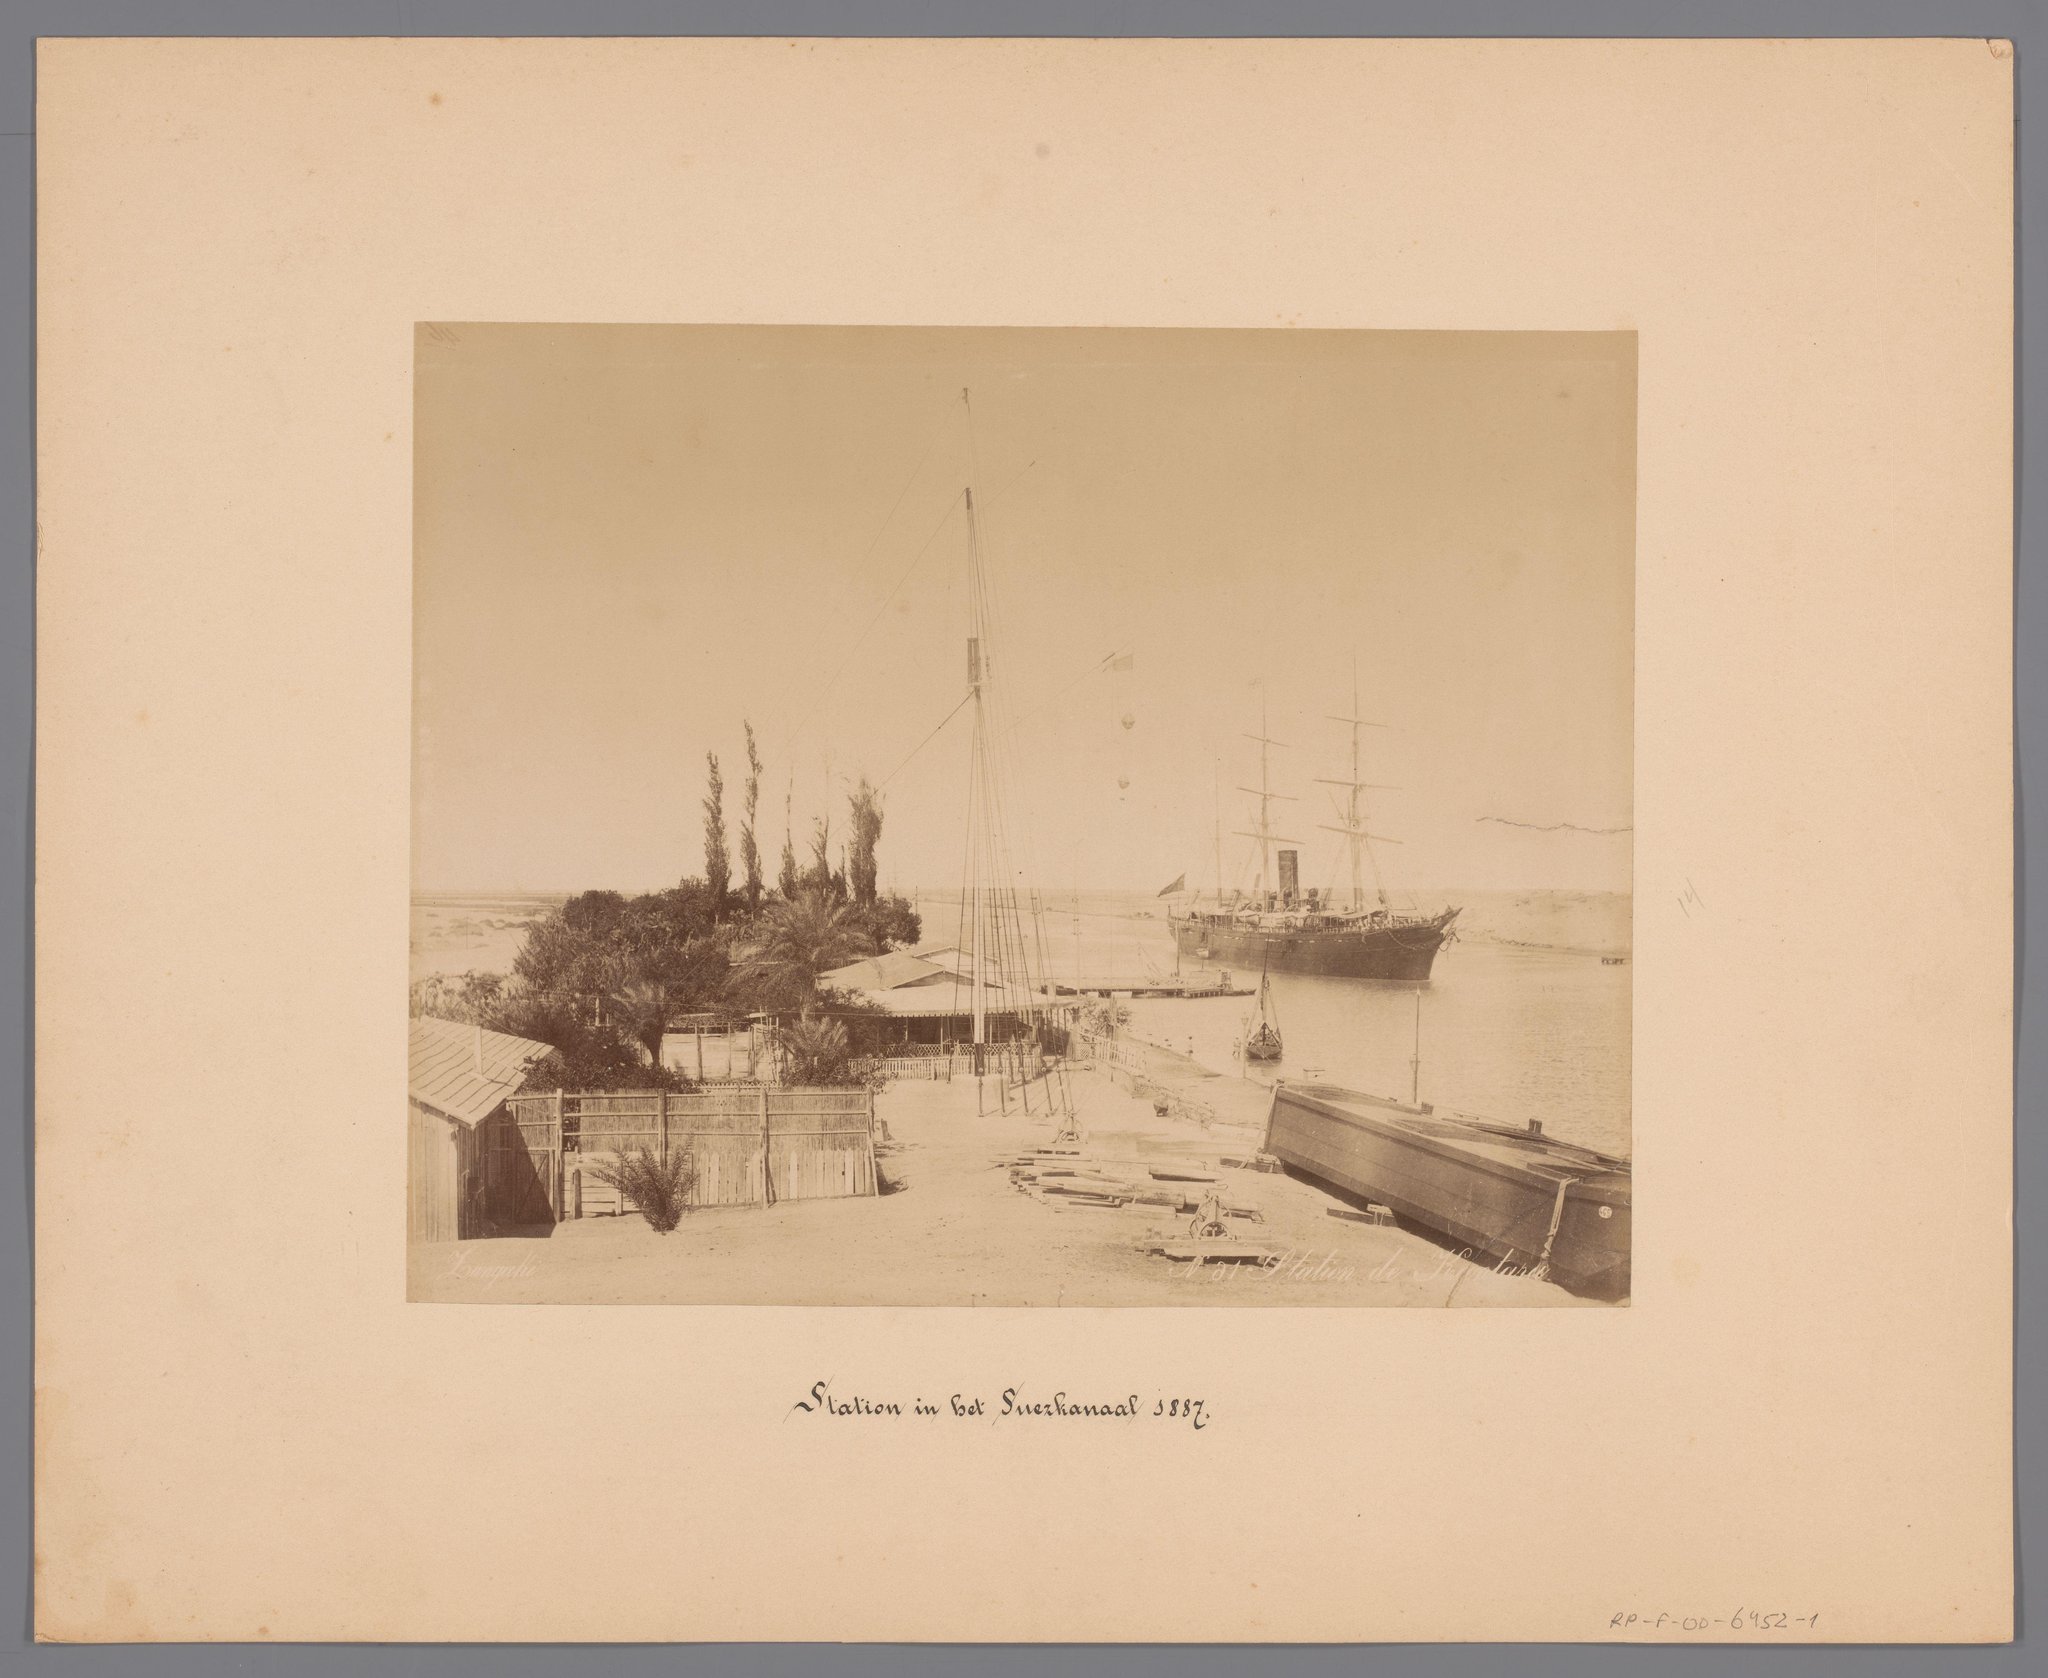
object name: photograph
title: Station in het Suezkanaal ('Station de Kantaru'), Egypte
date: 1887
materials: cardboard, paper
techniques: albumen print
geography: cairo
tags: suezkanaal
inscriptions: inscription: ‘No. 21 Station de Kantaru [sic]’, inscription: ‘Zangaki’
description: Gezicht een aanlegplaats en op het Suezkanaal met een schip rechts.